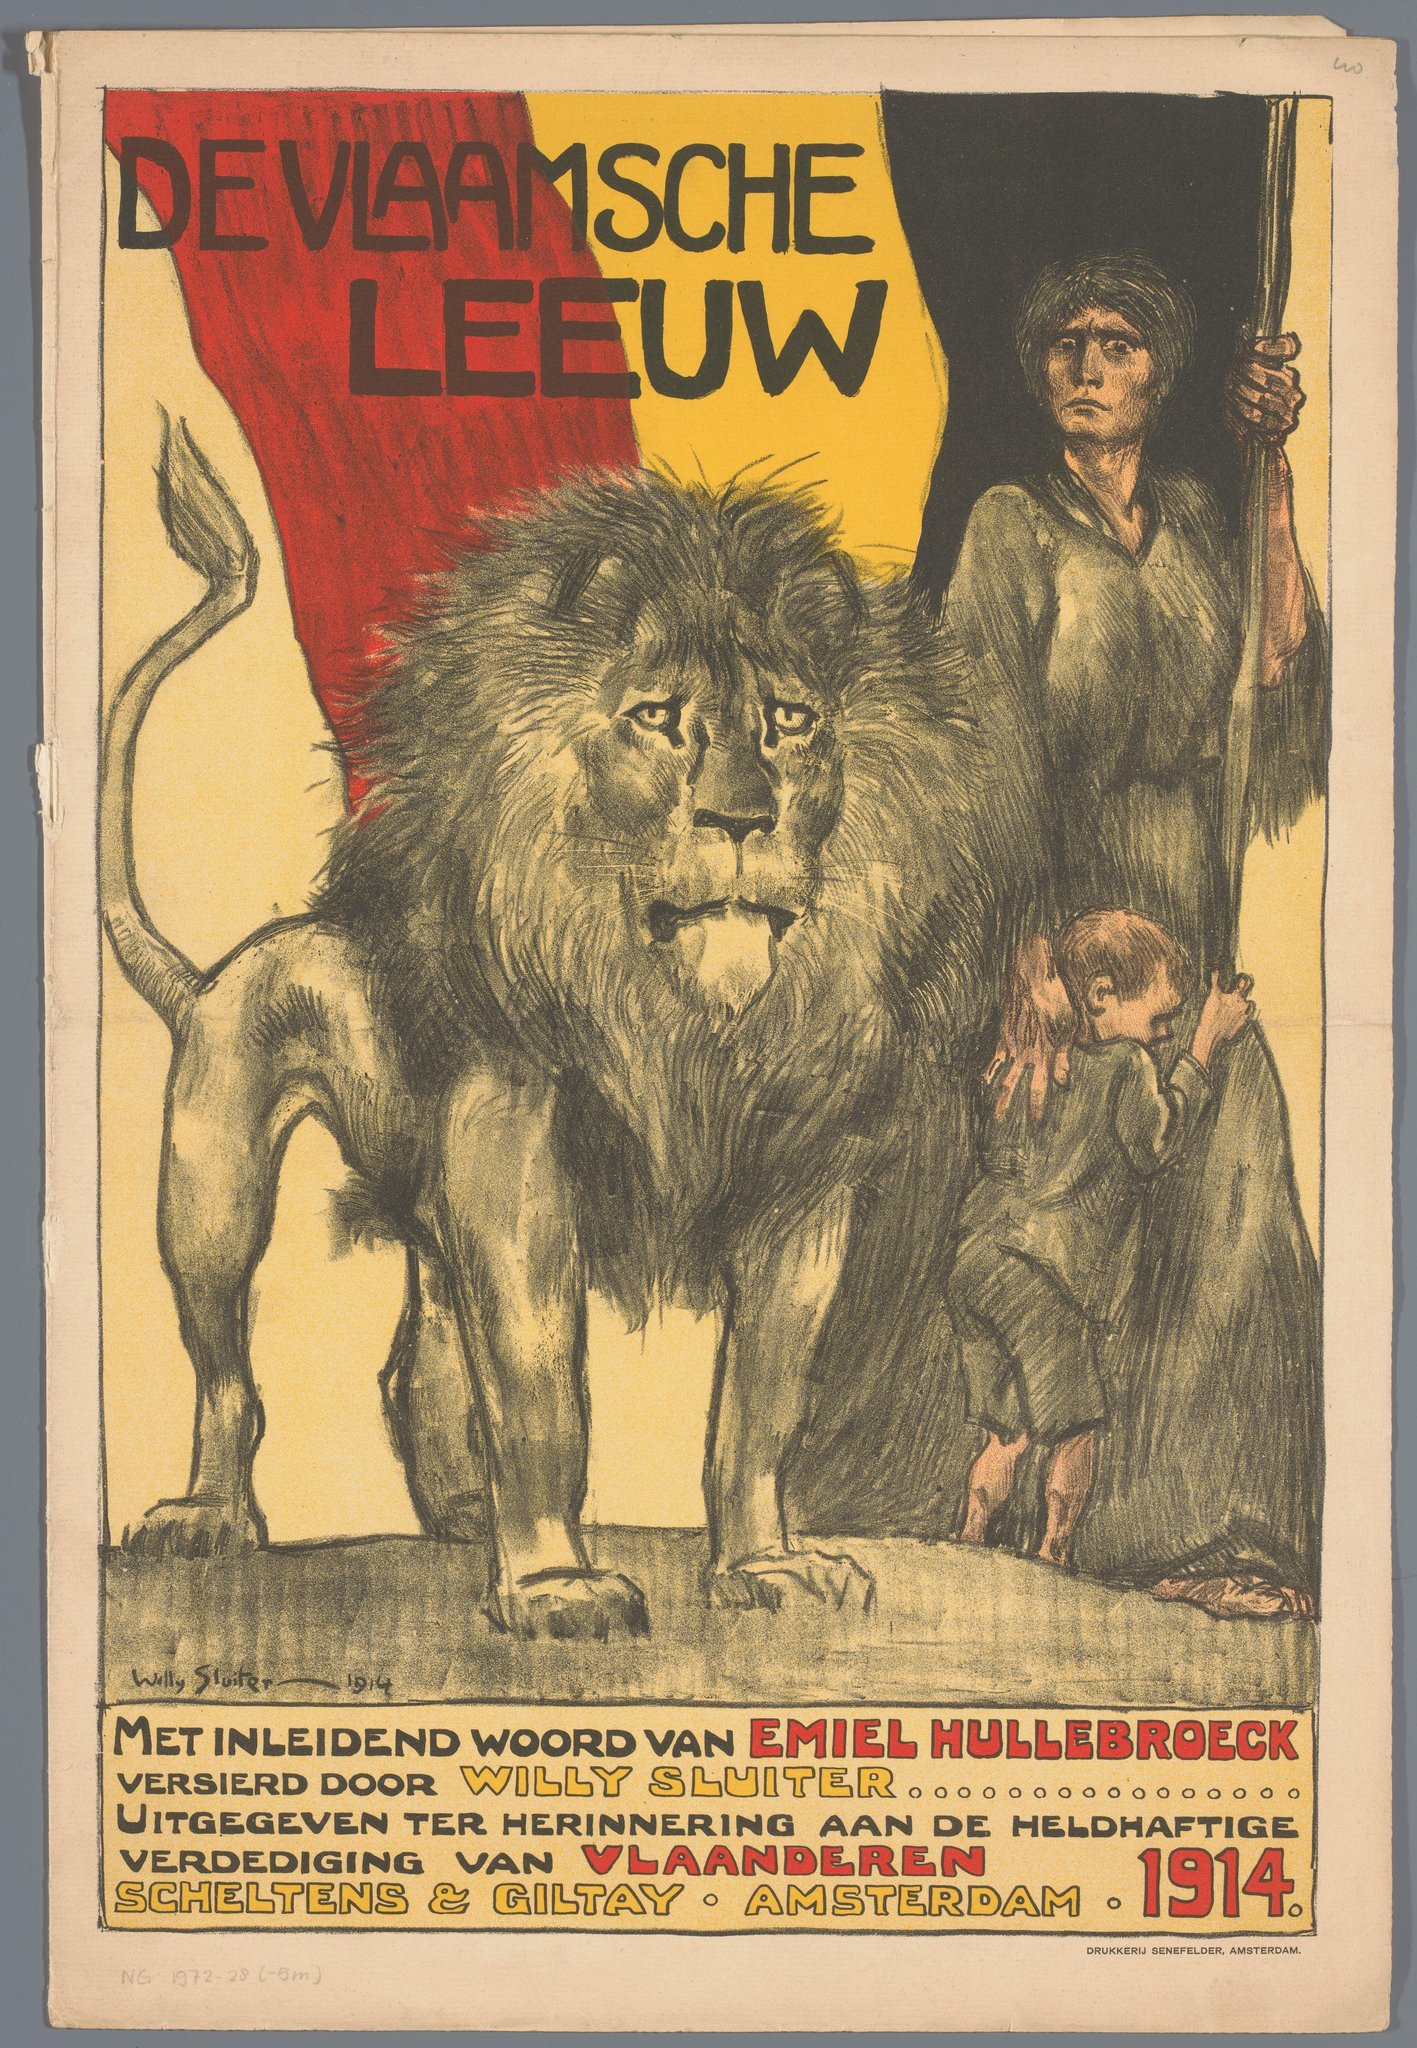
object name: song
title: De Vlaamsche Leeuw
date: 1914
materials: paper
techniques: lithograph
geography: amsterdam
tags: battle, printed edition of musical score, personifications of countries, nations, states, districts, etc. (+ nation; national), beasts of prey, predatory animals: lion, belgium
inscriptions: date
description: Brochure van acht bladzijden met de muziek en de tekst van het lied 'De Vlaamsche Leeuw'. Op de omslag de titel en een leeuw, waarachter een vrouw die de Belgische vlag vasthoudt, en een kind. Binnenin het lied tegen een achtergrond van een militaire actie door het Belgische leger. Bladzijden daarna zijn blanco. Volgens het voorwoord van Emiel Hullebroeck vervaardigd naar aanleiding van de heldhaftige verdediging van Vlaanderen tegen het oprukkende Duitse leger in december 1014.